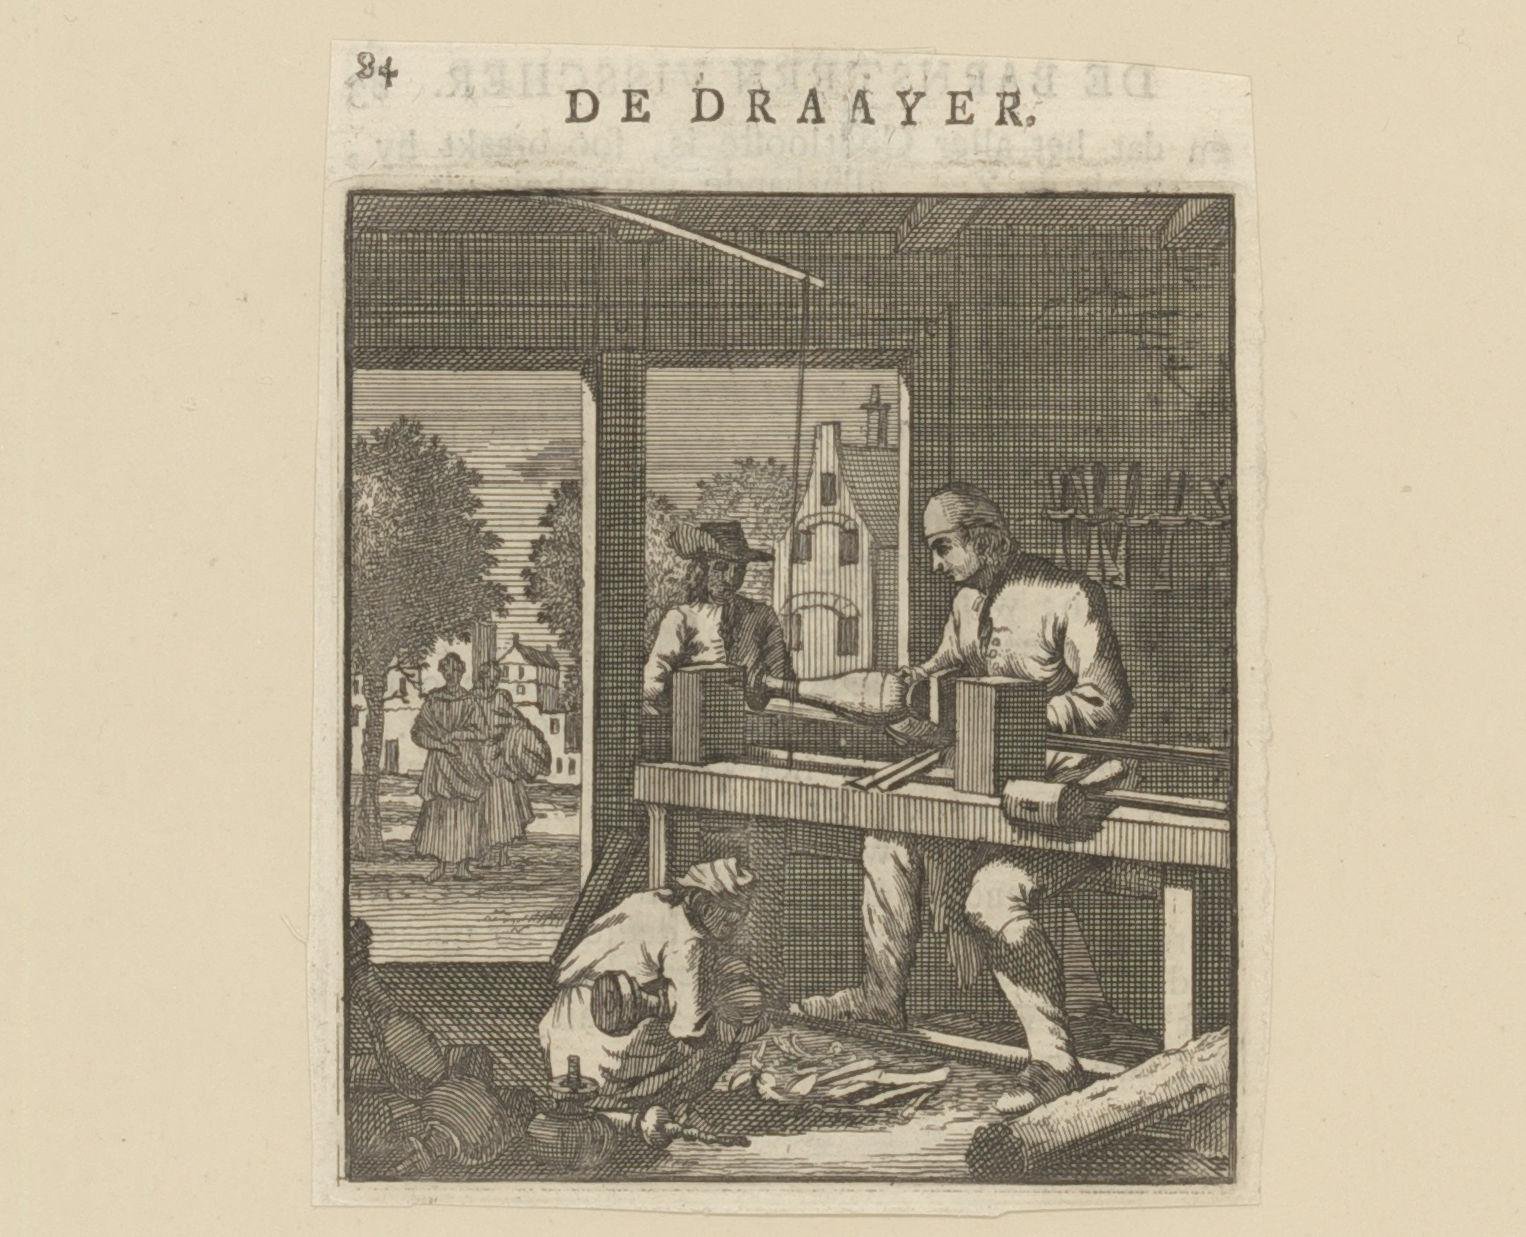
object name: print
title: De Draayer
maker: Anonymous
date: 1719-1759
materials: paper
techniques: etching, letterpress printing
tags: turner in wood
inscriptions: stamp, collector's mark: Lugt 1641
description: Prent met andere letterzetting gebruikt in: St. Clara, Abraham van. Iets voor allen. [Vertaald door] J. le Long. Amsterdam: Janssoons van Waesberge, 1719, dl. 2. En in: St. Clara, Abraham van. Iets voor allen. [Vertaald door] J. le Long. Amsterdam: Jan Roman de Jonge, 1741, dl. 2. En in: St. Clara, Abraham van. Iets voor allen. [Vertaald door] J. le Long. Amsterdam: Jan Roman, 1759, dl. 2. Huidige prent uit een andere editie. Naar een prent van: Jan Luyken.